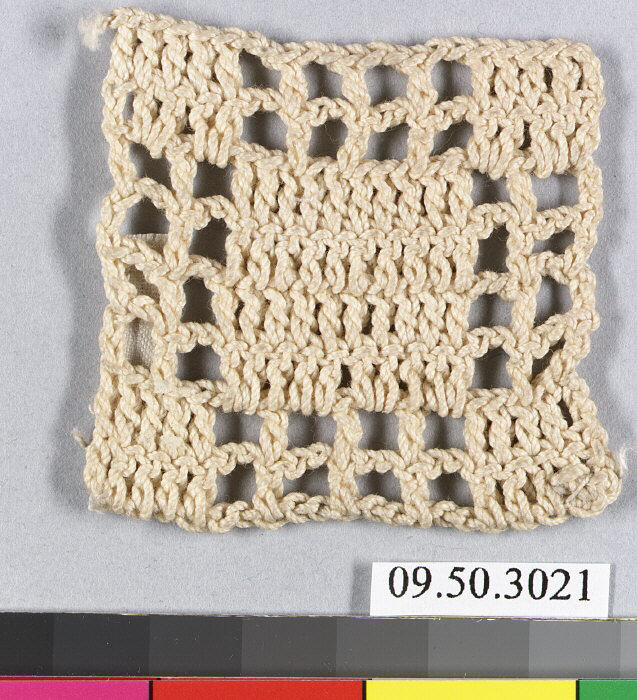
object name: sample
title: Crochet work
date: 1801-1900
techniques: crochet